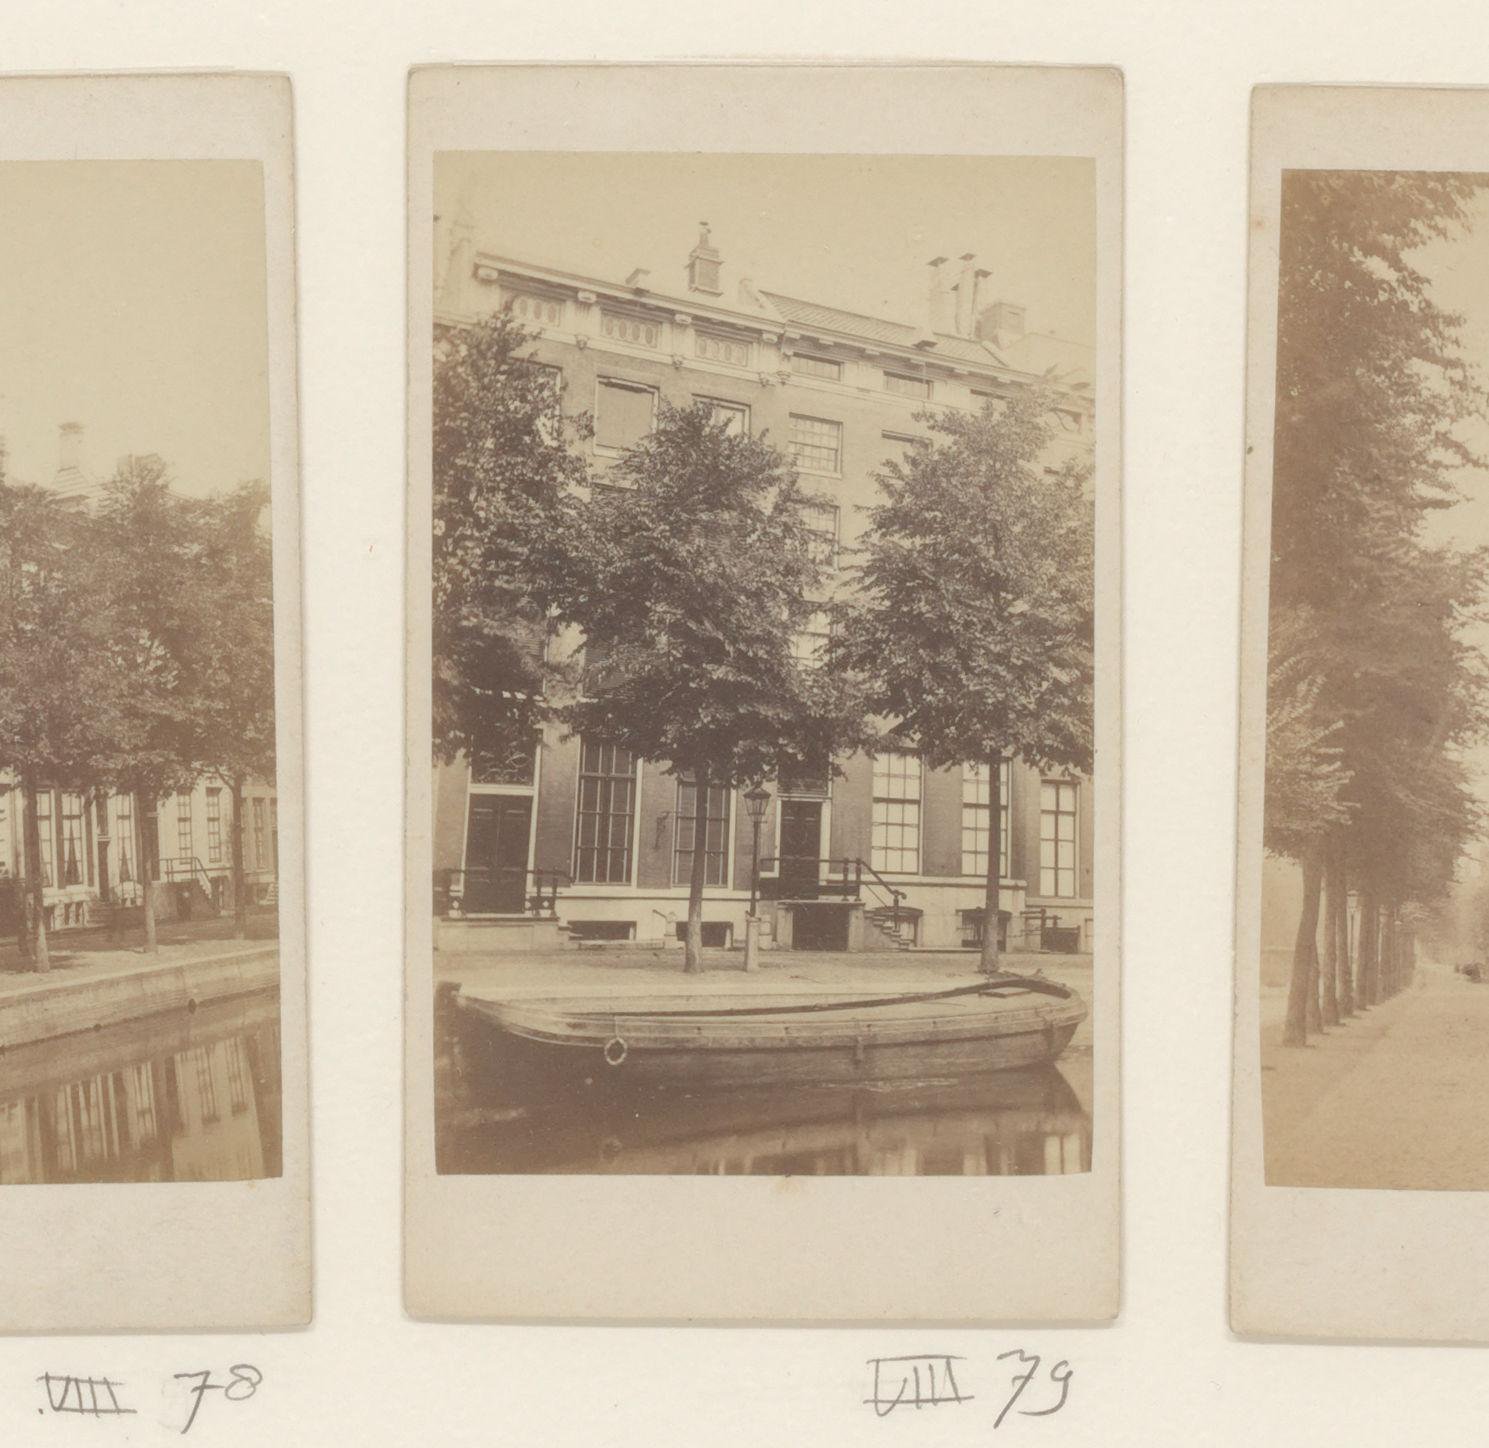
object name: carte de visite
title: Gezicht op de Herengracht bij de Herenstraat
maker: andries jager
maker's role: publisher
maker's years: 1825-1905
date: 1849-1885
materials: cardboard, paper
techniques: albumen print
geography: amsterdam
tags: city-view in general; 'veduta', canal, the usual house or row of houses, façade (of house or building)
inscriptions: inscription: ‘Heerengr bij de / Heerenstraat’, stamp: ‘A. Jager / Water. 110. / Amsterdam.’, collector's mark: ‘8,79’ Lugt 1641b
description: Onderwerpsrubriek binnen de Atlas Amsterdam: Haarlemmerplein, Halvemaansteeg, Handboogstraat, Handelskade, Haringpakkerij, Hartenstraat, Hasseltsteeg (Dirk van), Heerengracht.